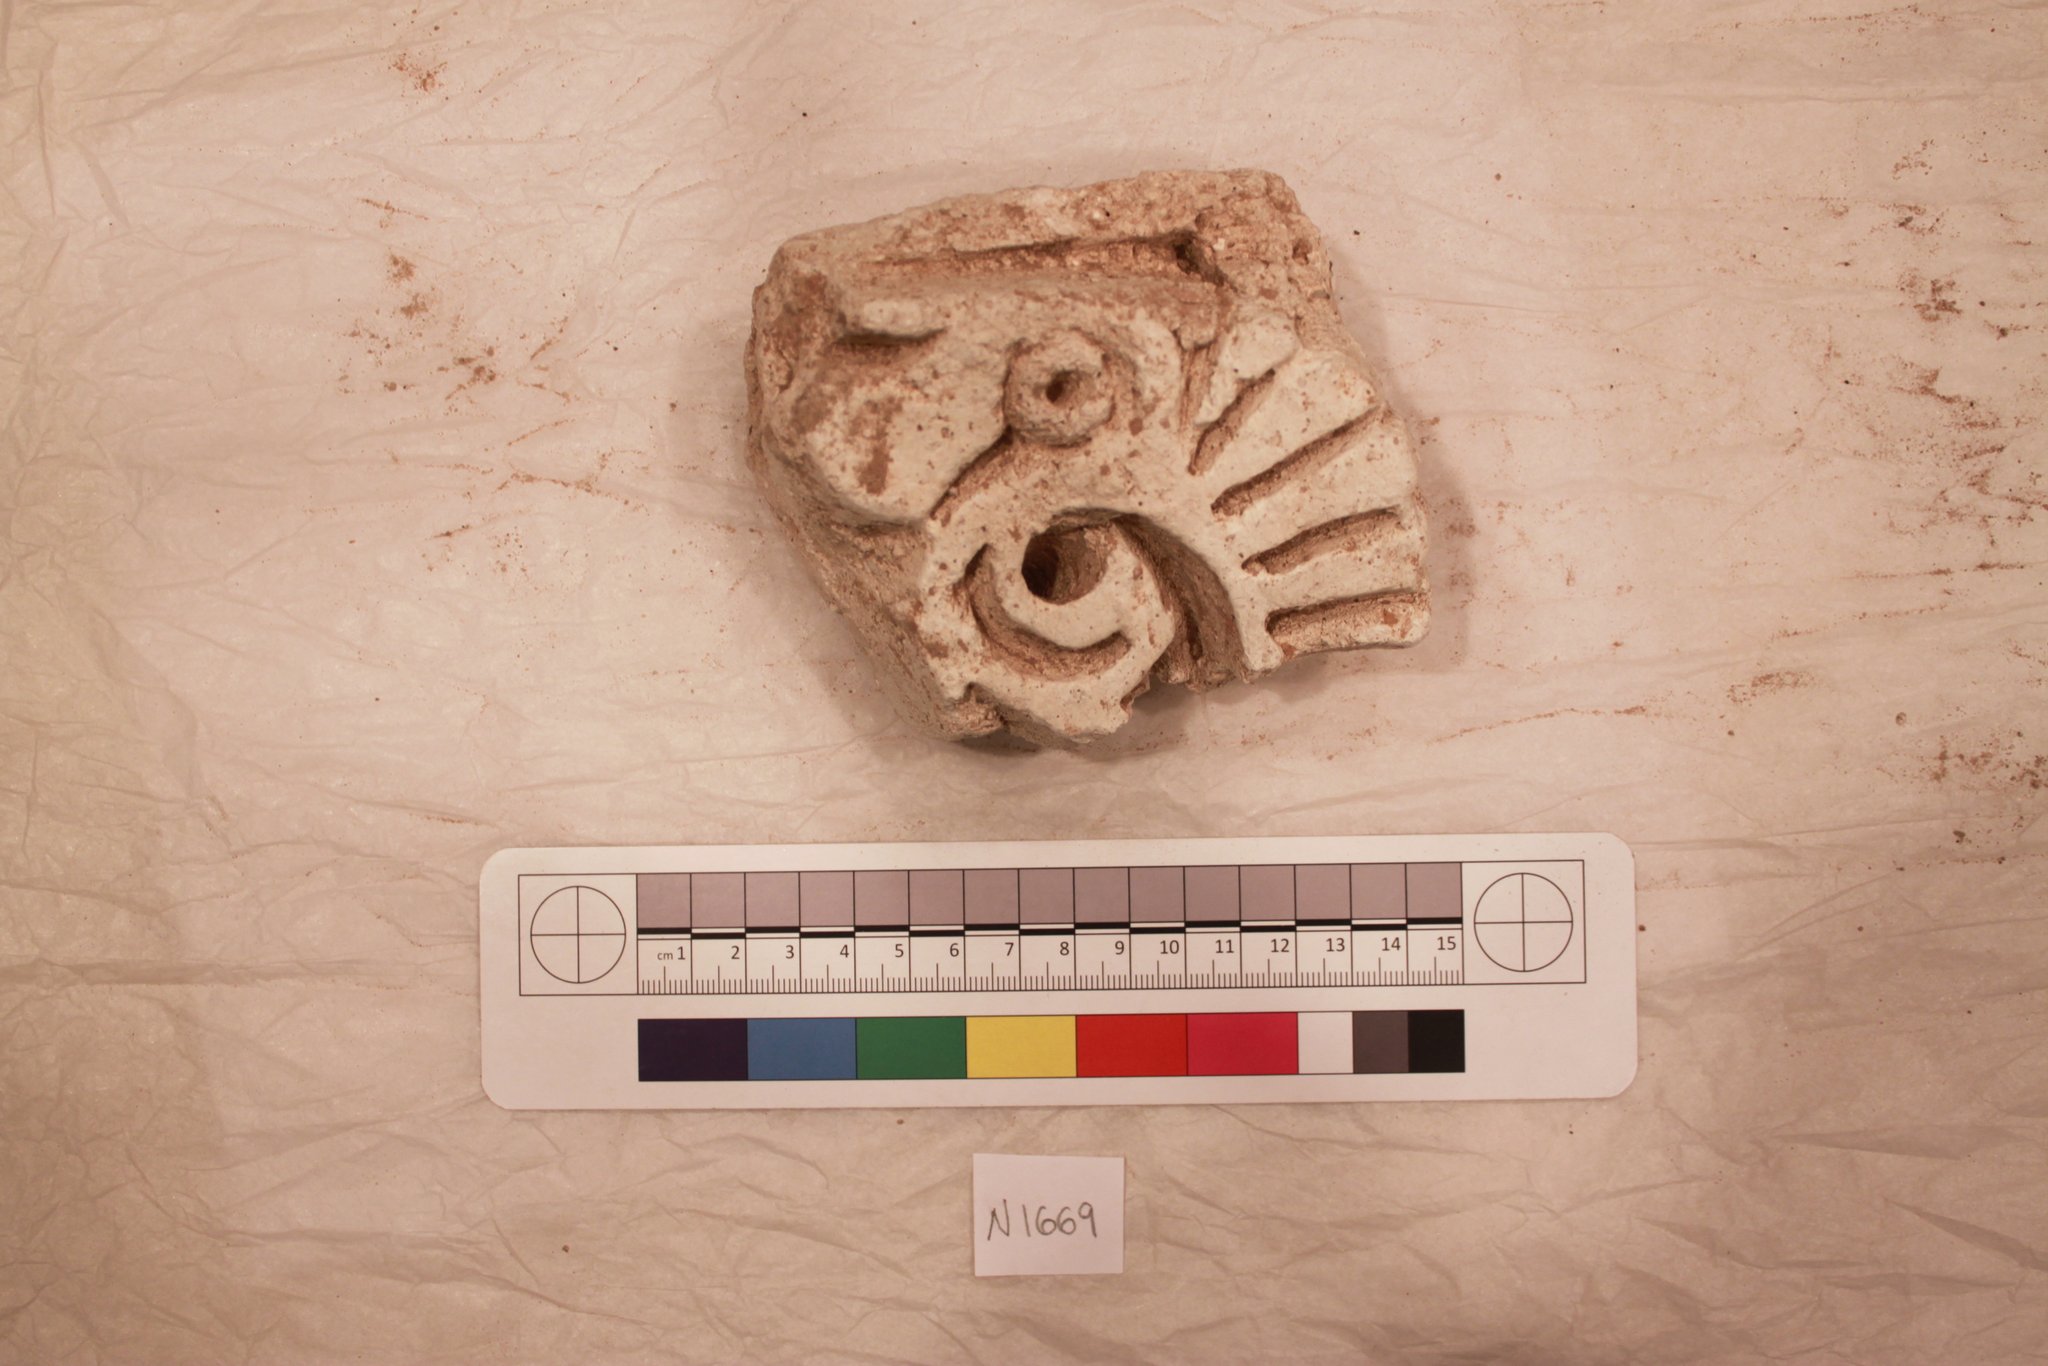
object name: fragment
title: Stucco Fragment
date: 701-1200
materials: plaster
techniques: carving, painting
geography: iran